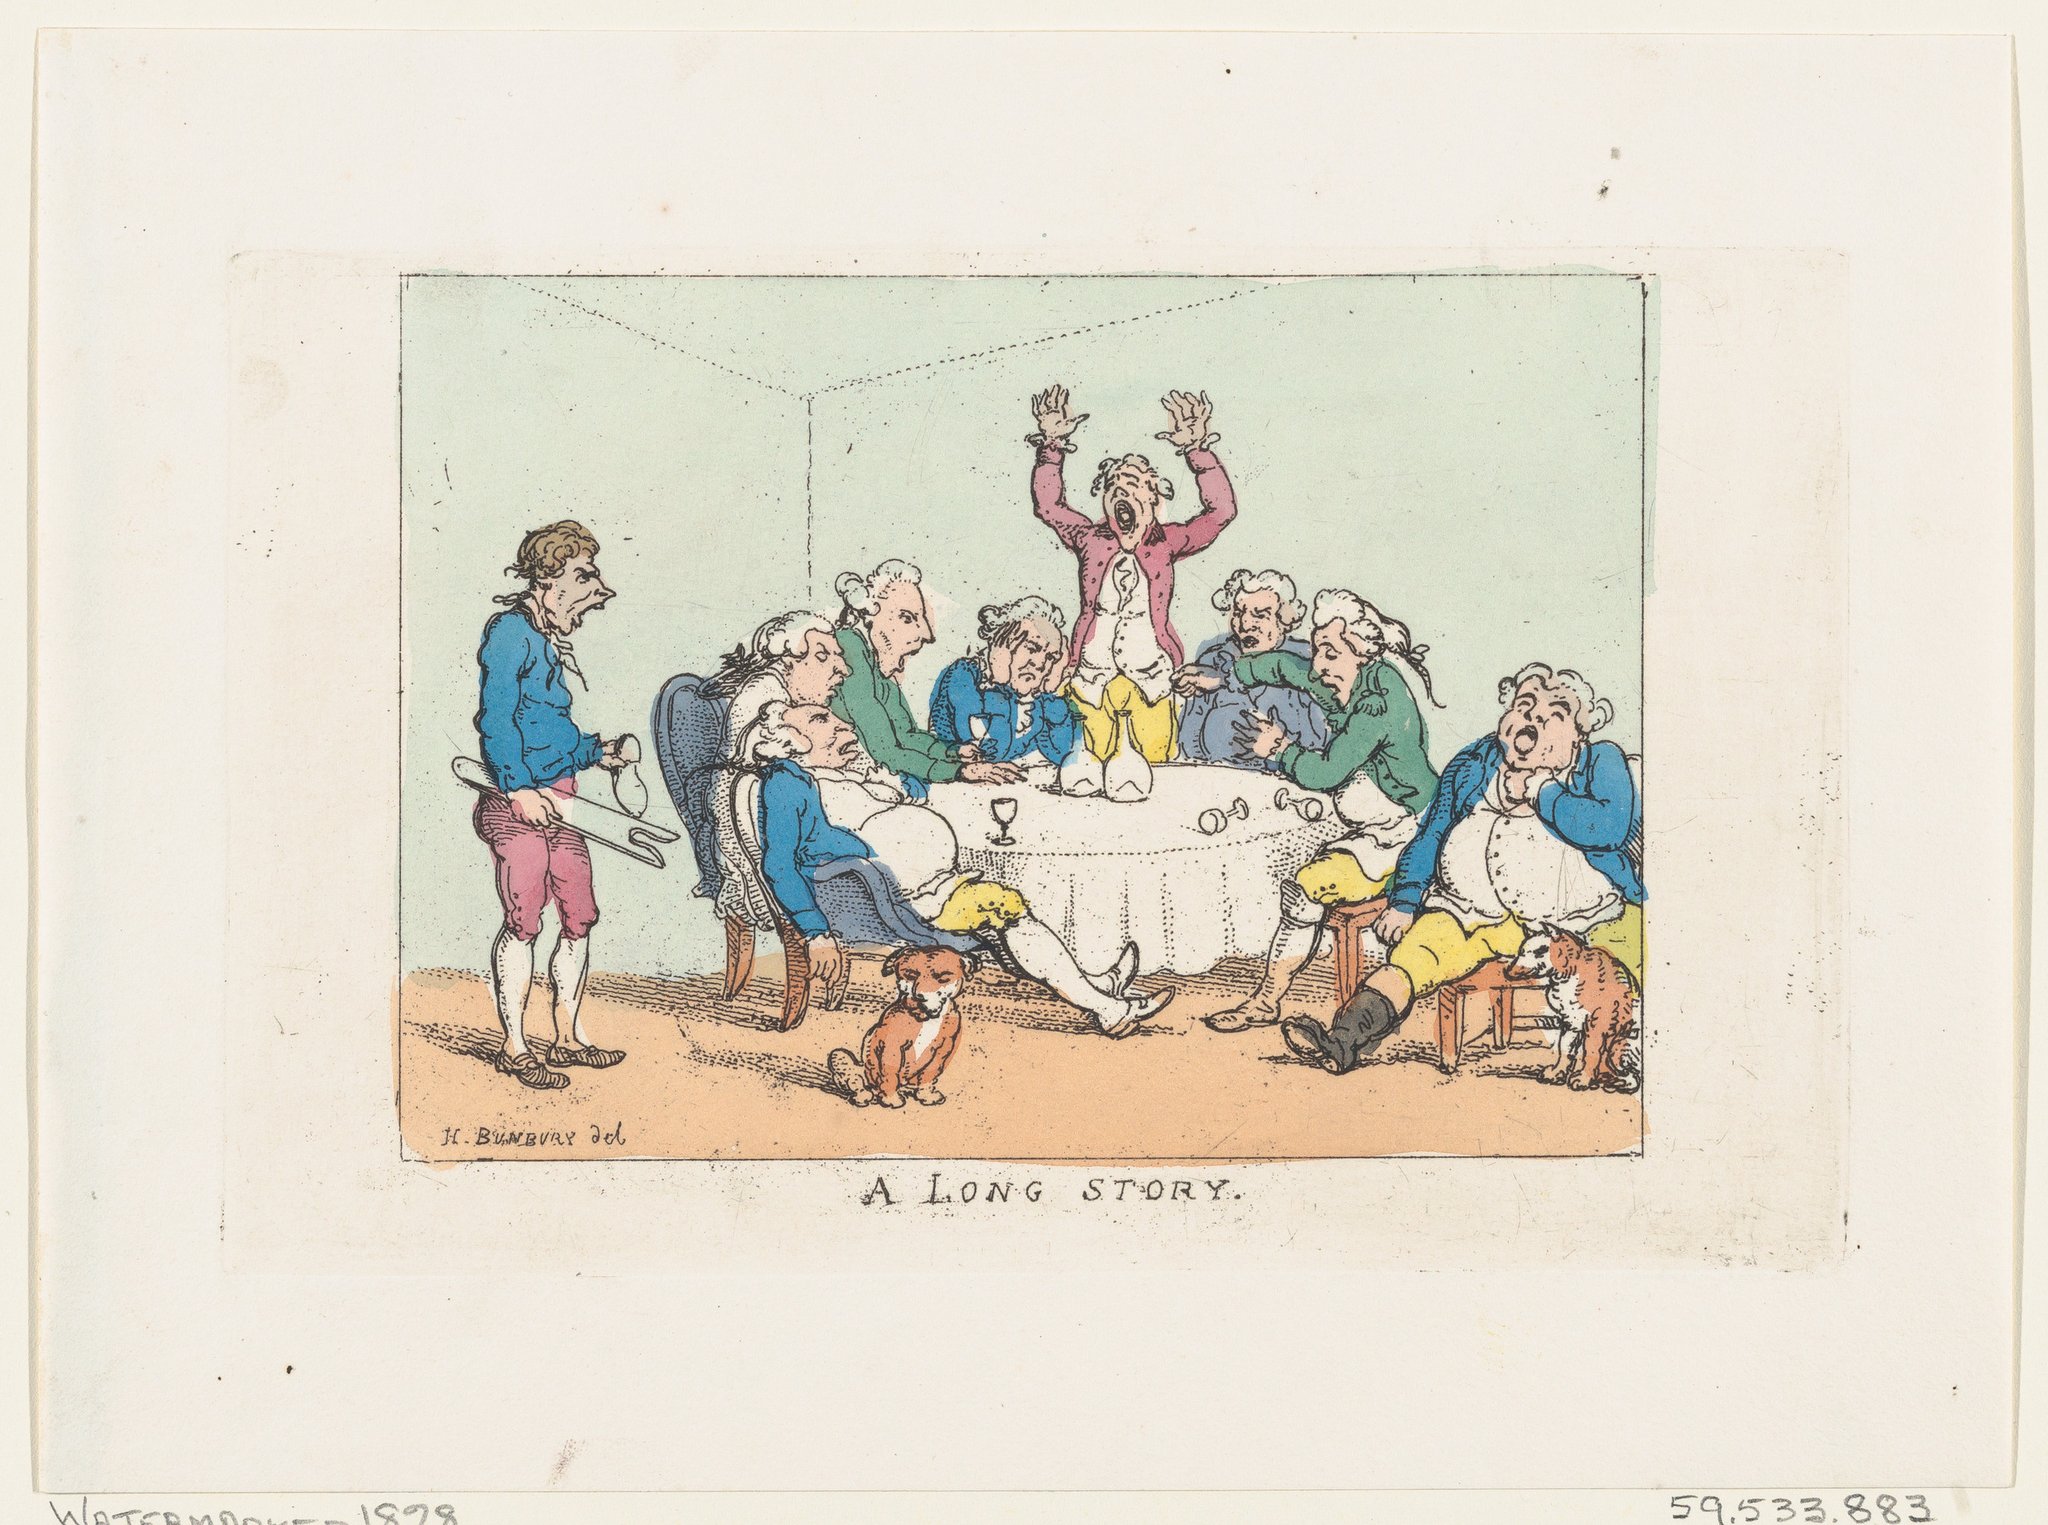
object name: print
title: A Long Story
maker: henry william bunbury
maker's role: artist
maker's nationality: british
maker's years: 1750-1811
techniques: etching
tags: satire,men,dogs,servants